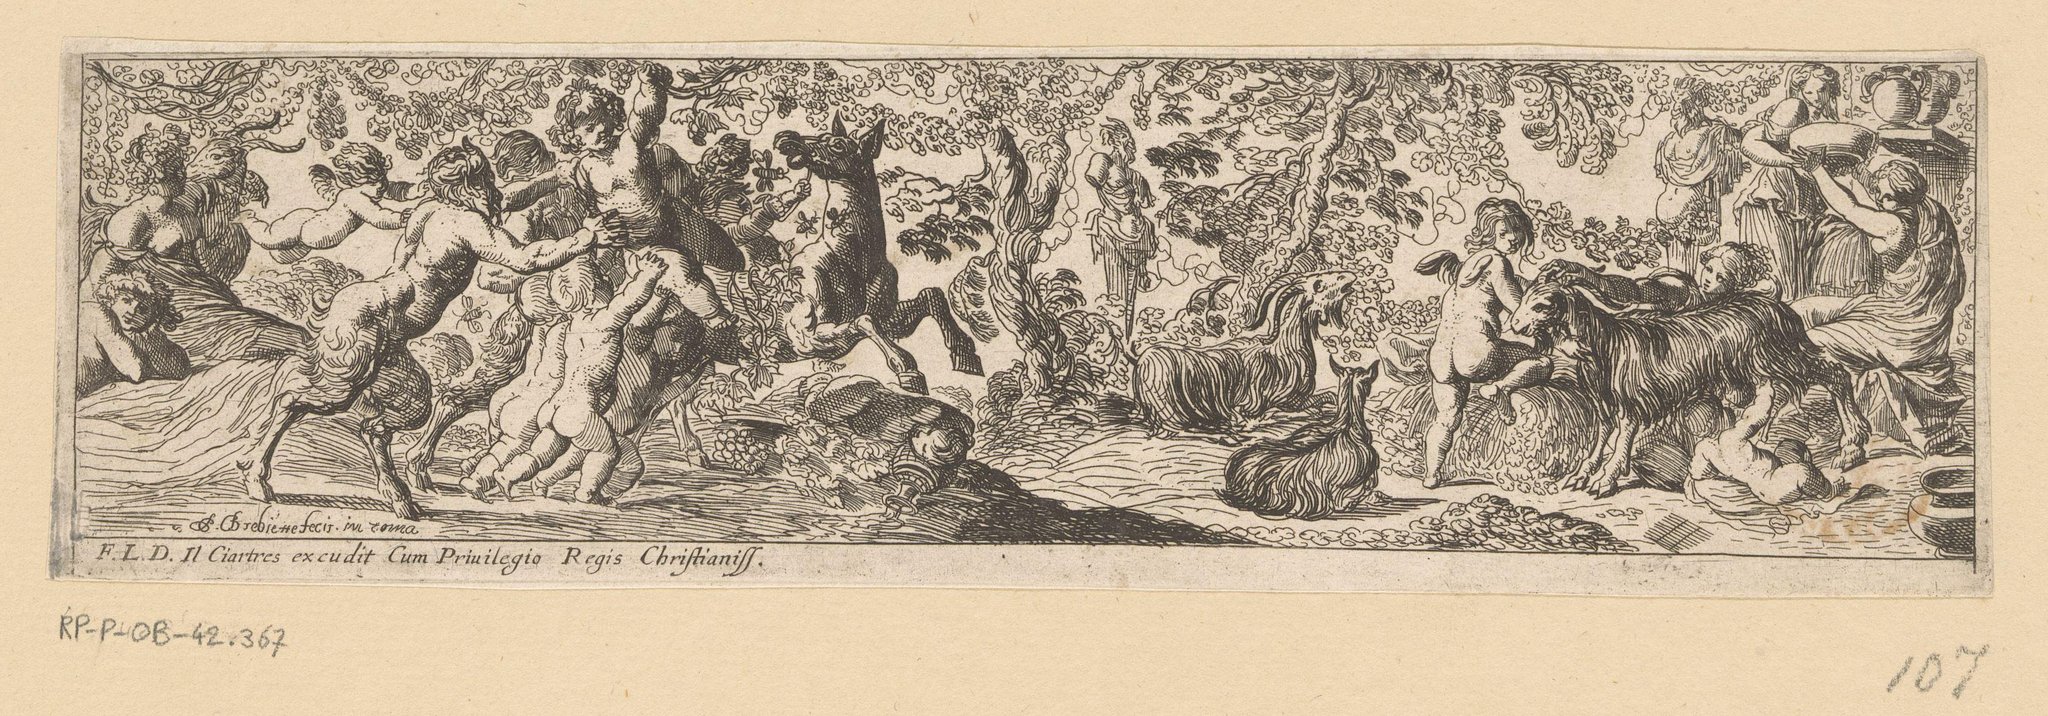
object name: print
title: Bacchanten met ezel en bokken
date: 1617-1626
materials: paper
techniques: etching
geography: rome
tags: children's bacchanal, ass, donkey, goat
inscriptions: collector's mark: Lugt 240